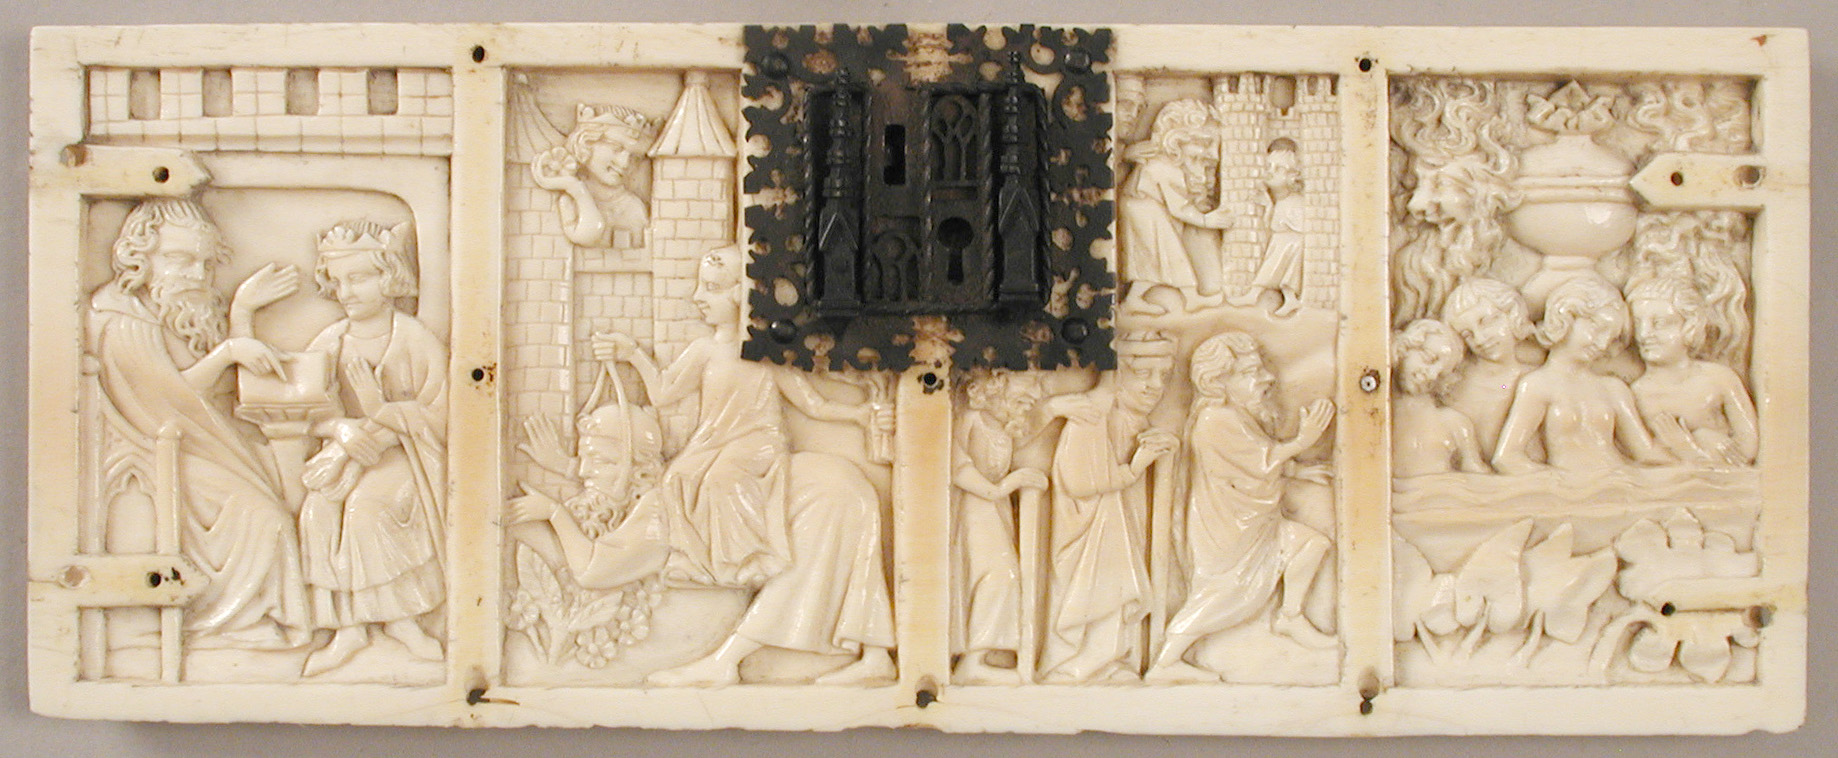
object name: panel, from a box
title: Panel from a Box with Scenes from Romance Literature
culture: european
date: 1801-1900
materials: ivory